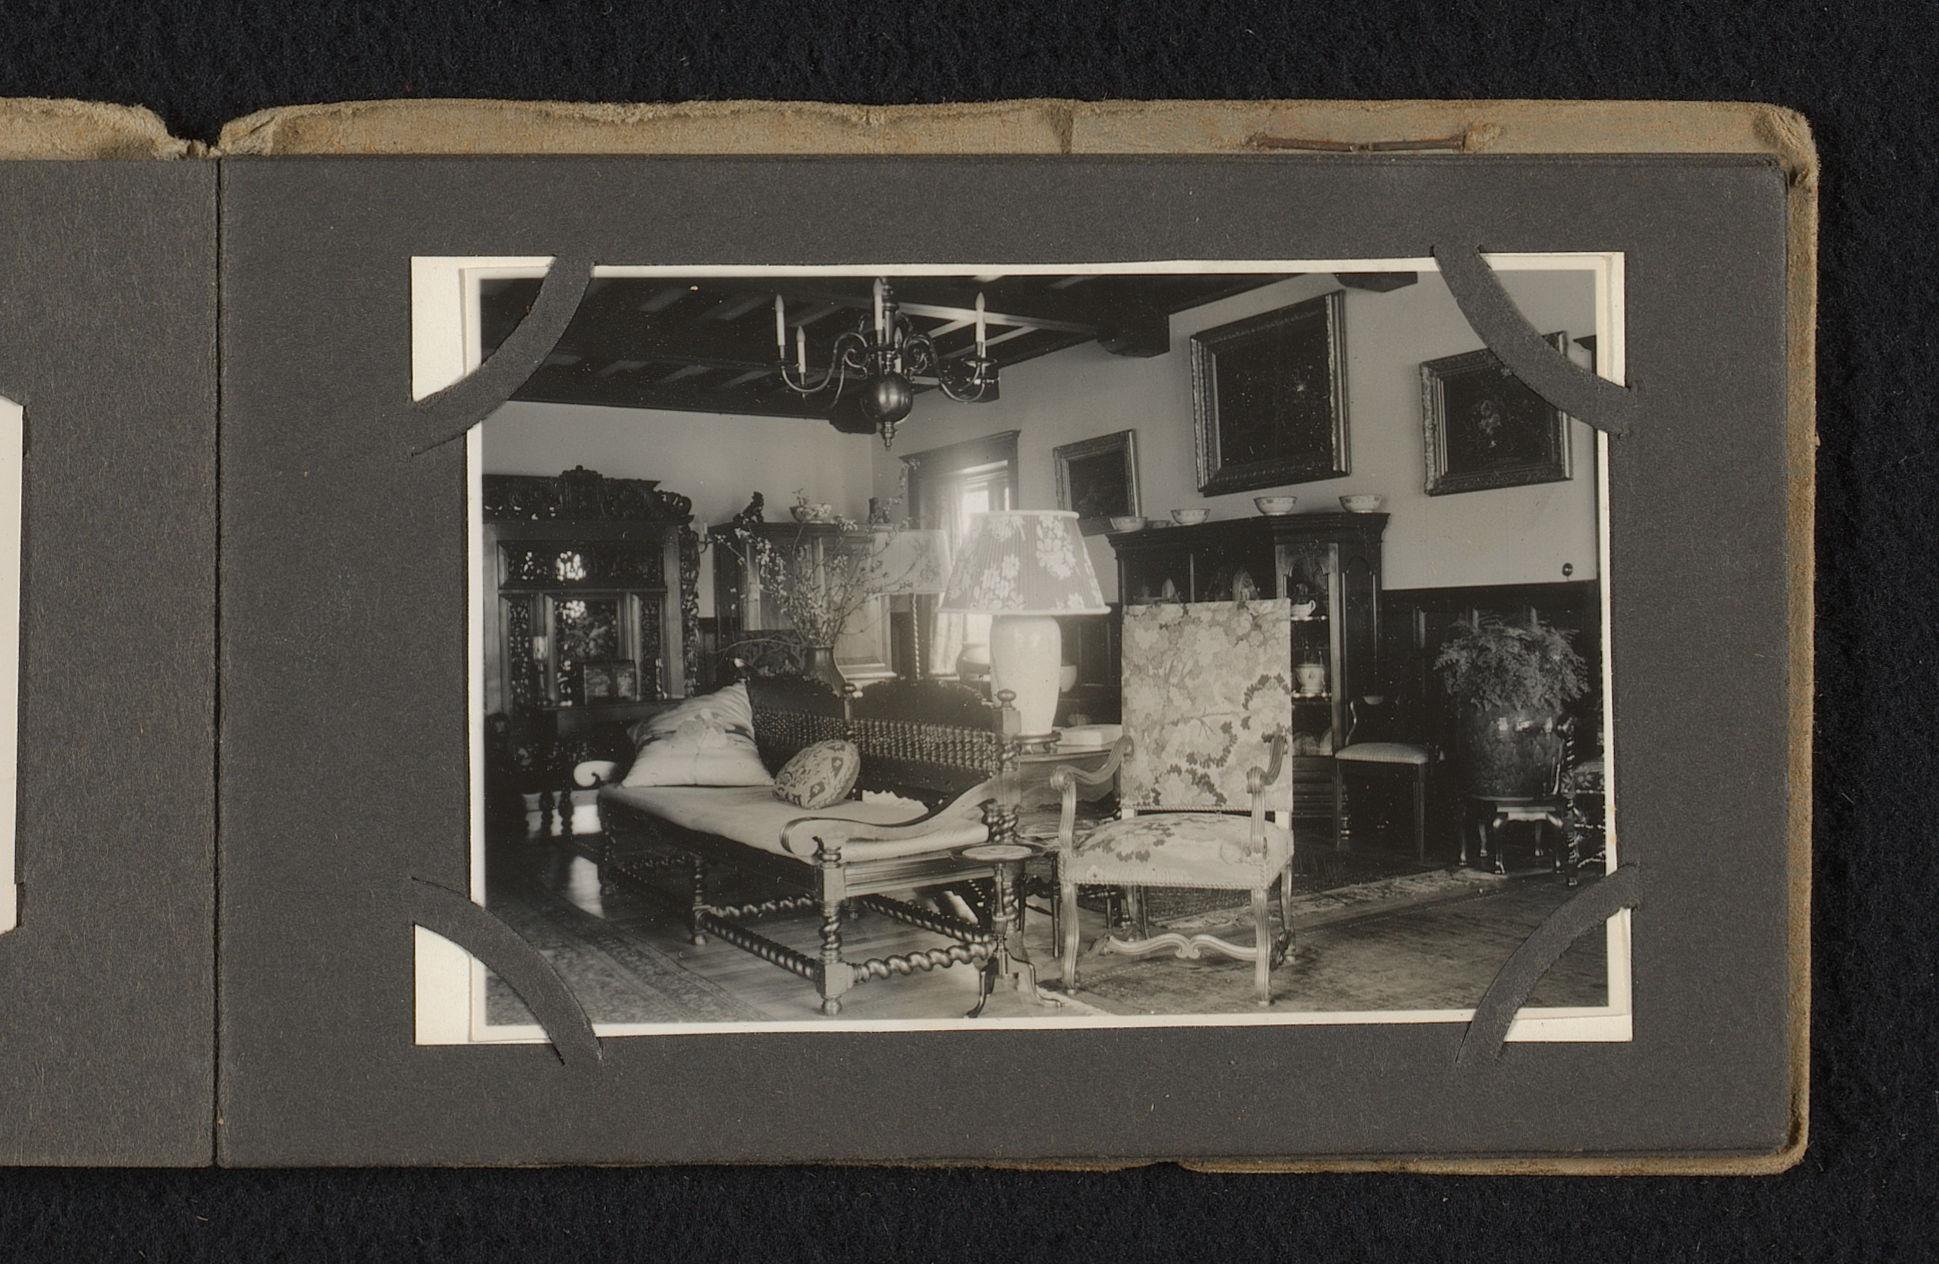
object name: photograph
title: Interieur van het landhuis De Wilde Zwanen te Laren, met bank en stoel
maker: norbert van den berg (1901-1972)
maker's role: amateurfotograaf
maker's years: 1901-1972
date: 1940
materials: paper, cardboard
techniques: gelatin silver print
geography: laren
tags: interior of the house, chair, couch, sofa, settee